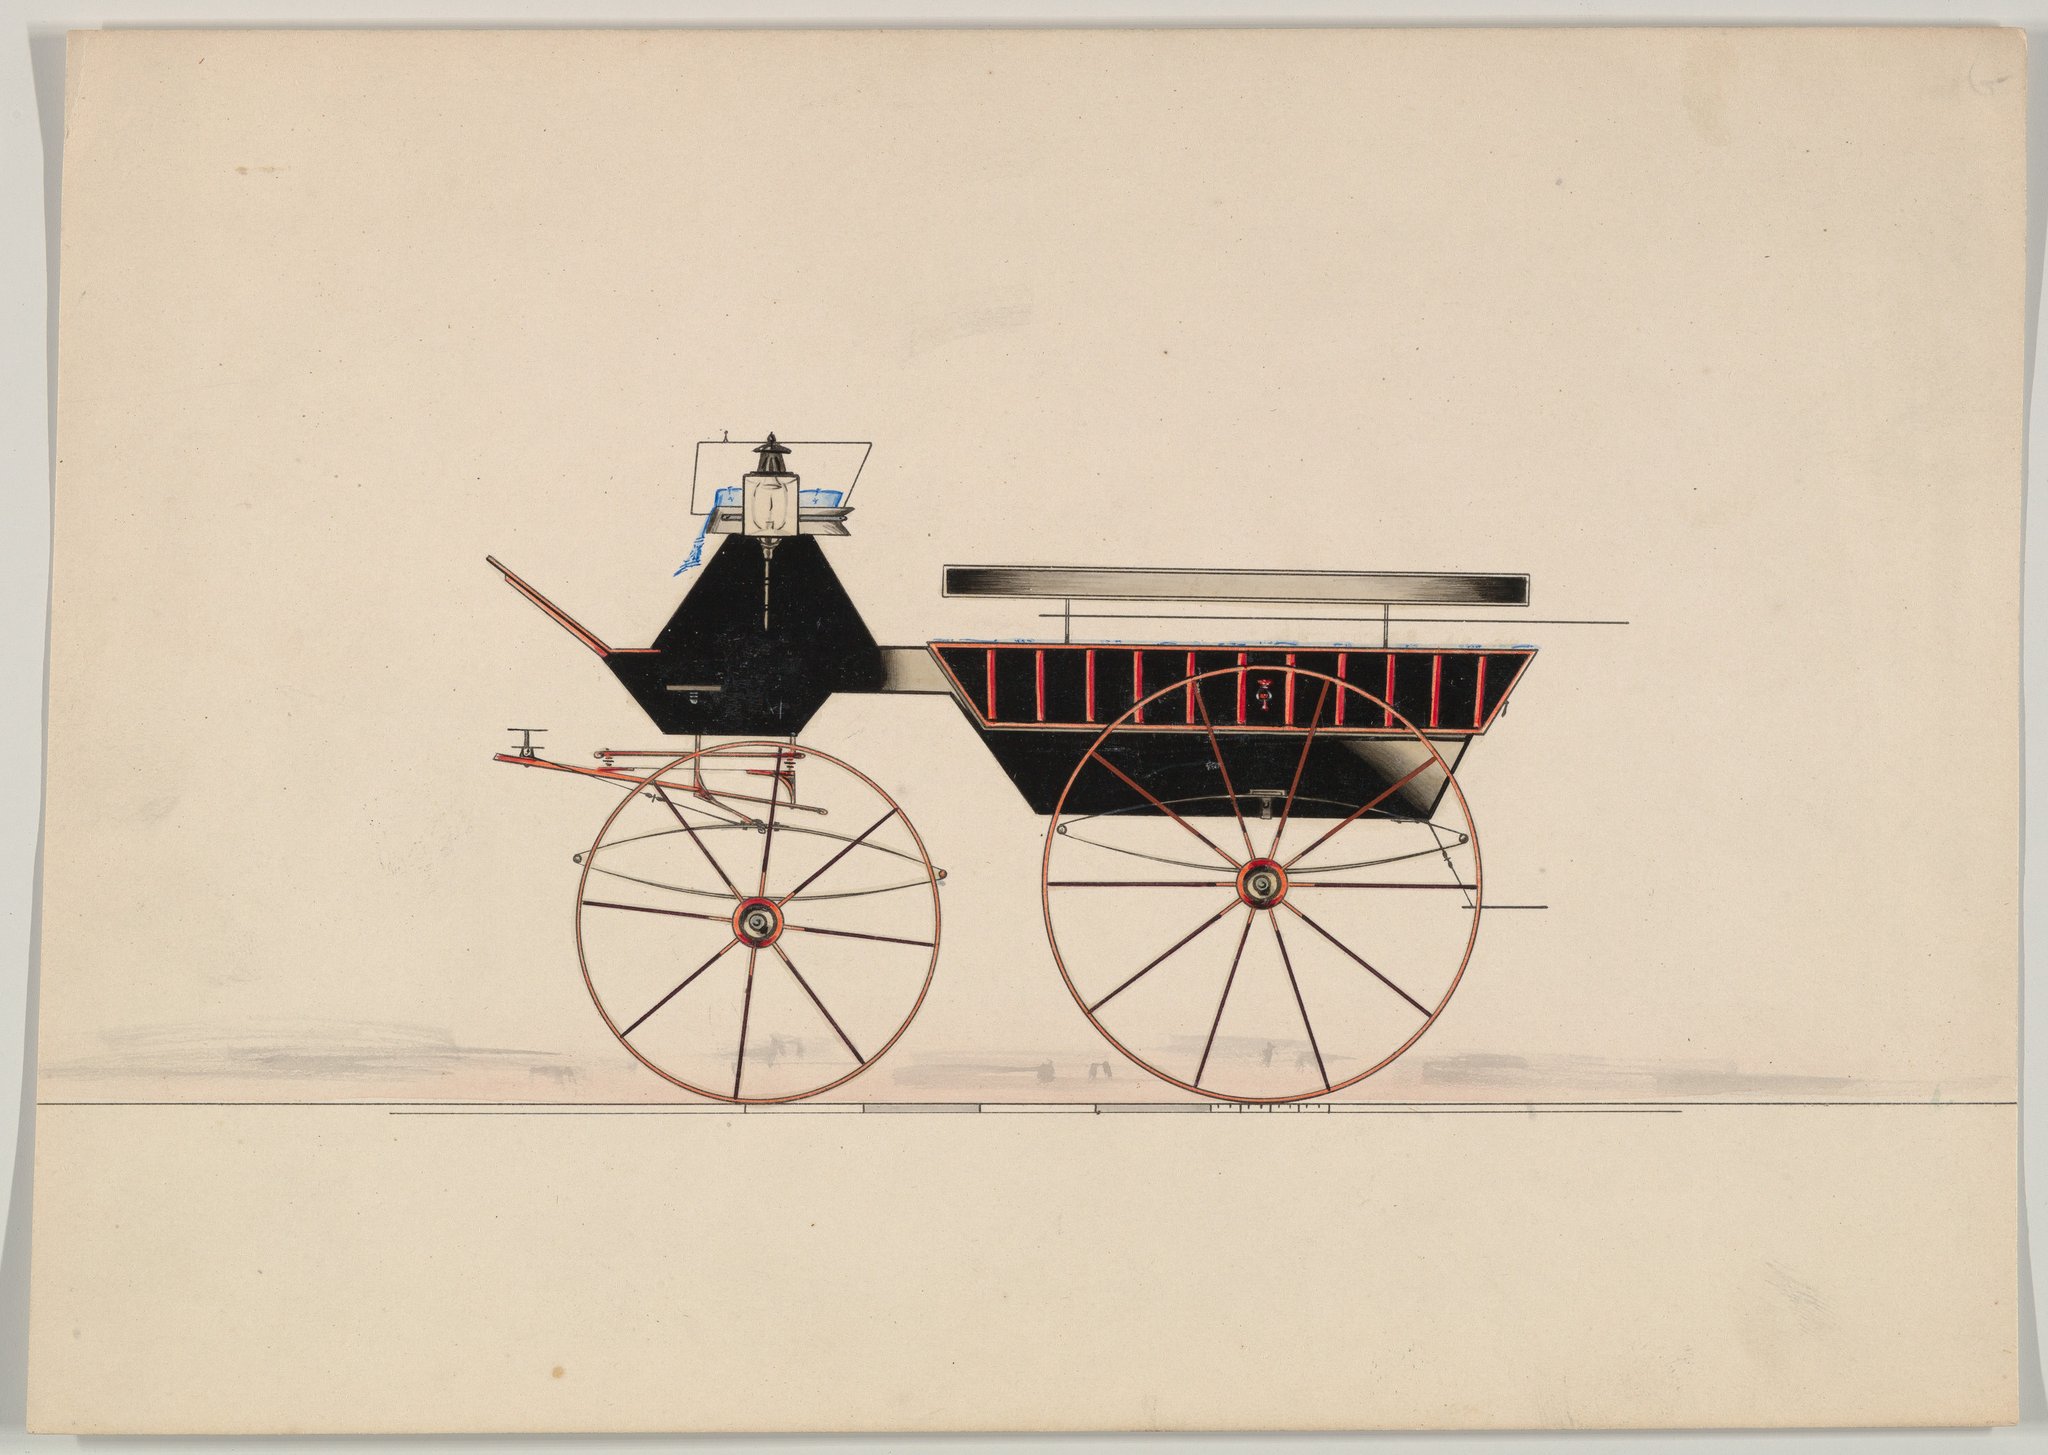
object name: drawing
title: Wagonette (unnumbered)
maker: brewster & co.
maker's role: manufacturer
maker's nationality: american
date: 1850-1870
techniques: hand coloring, lithograph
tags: carriages